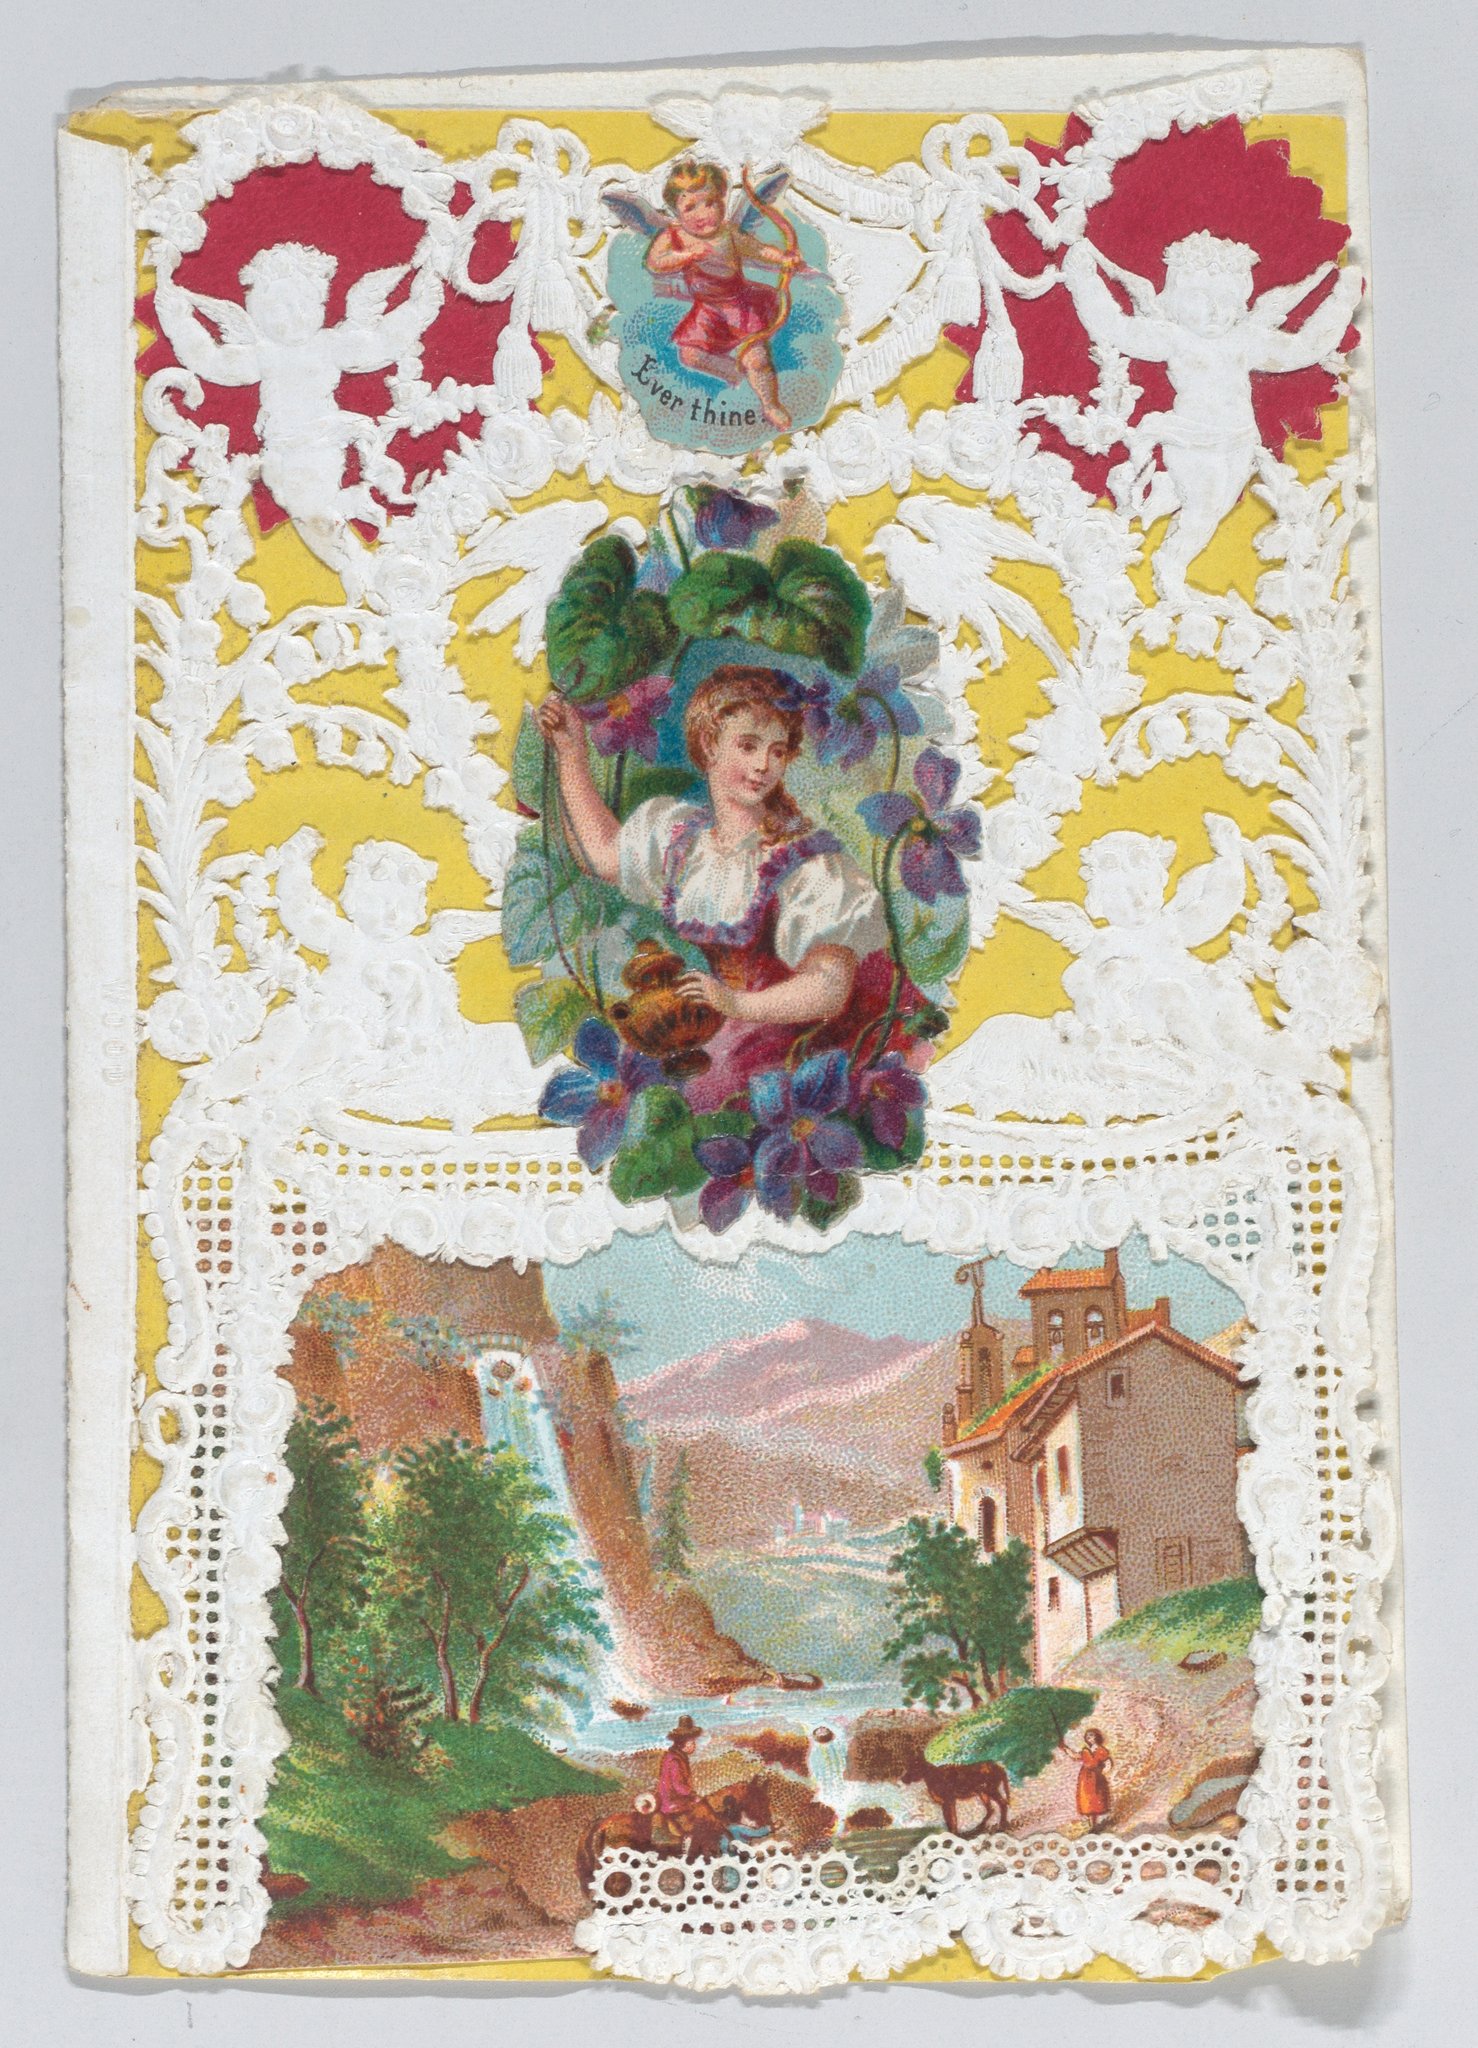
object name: valentine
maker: esther howland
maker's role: artist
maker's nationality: american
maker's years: 1828-1904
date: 1850-1870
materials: lace, paper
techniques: chromolithography, embossing, open work